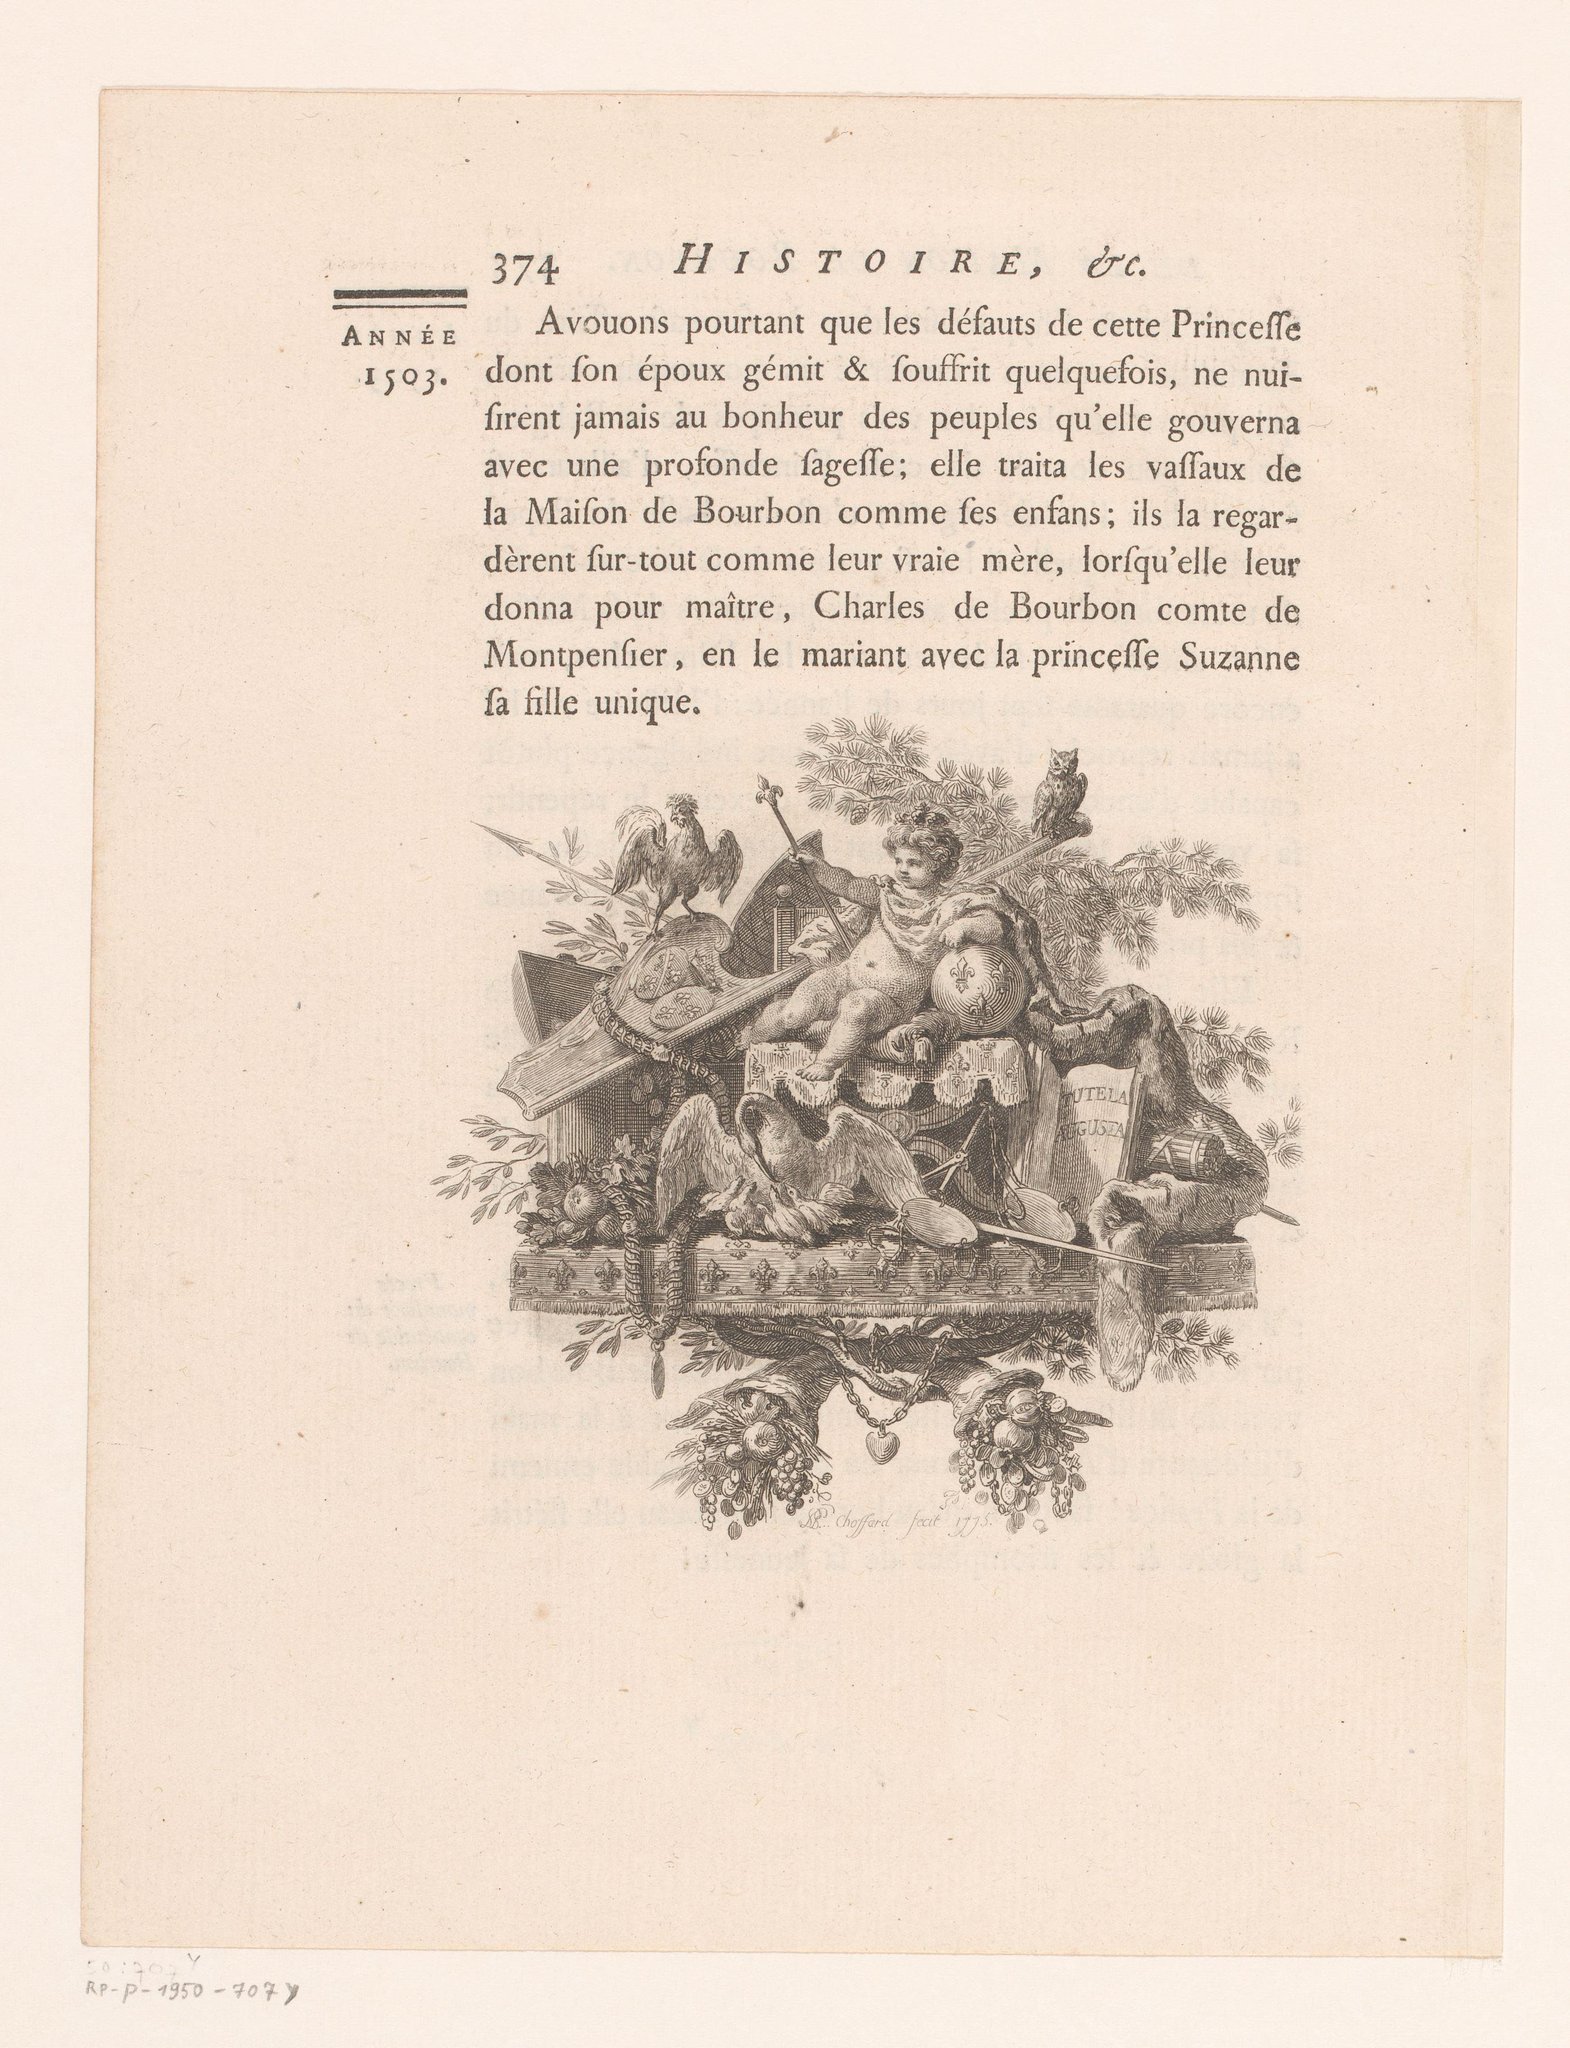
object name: book illustration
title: Allegorische voorstelling met gekroonde cherubijn en vogels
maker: pierre philippe choffard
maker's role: print maker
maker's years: 1730-1809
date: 1775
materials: paper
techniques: engraving, etching, letterpress printing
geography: paris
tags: crown (symbol of sovereignty), symbols of christ ~ animals, owls, fowl (cock, hen, chicken, etc.), cupids: 'amores', 'amoretti', 'putti', water-birds: pelican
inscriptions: collector's mark: Lugt 2228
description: Prent uit: Désormeaux, Joseph-Louis-Ripault. Histoire de la maison de Bourbon. Parijs: L'imprimerie royale, 1776, dl. 2.